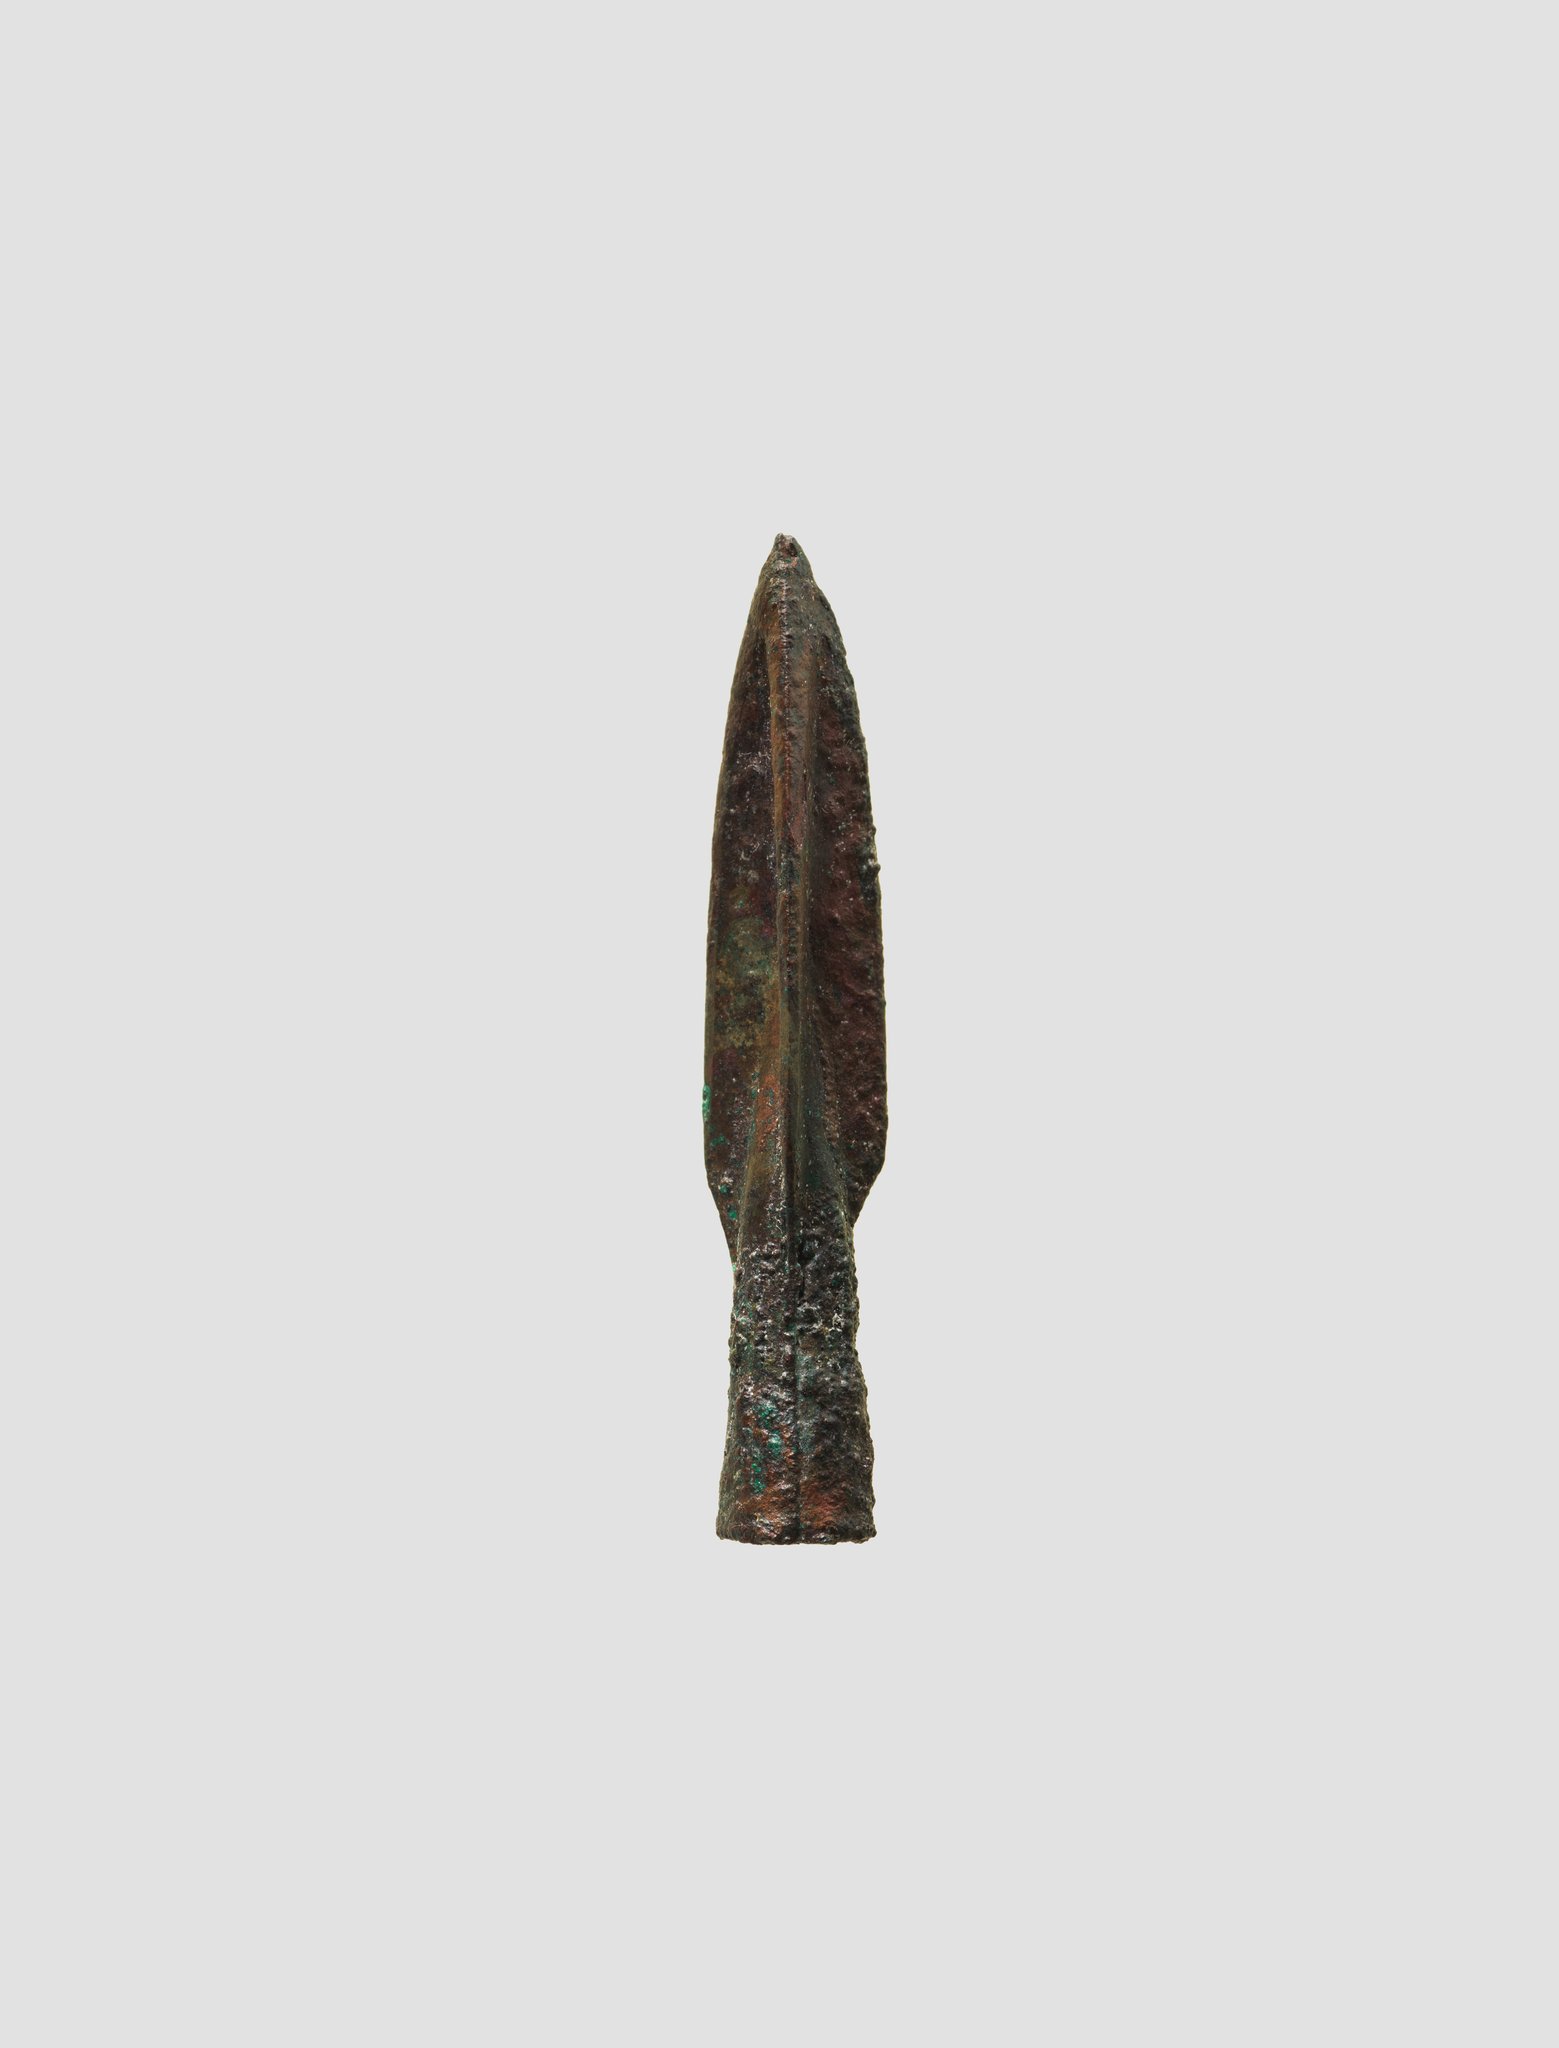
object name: arrowhead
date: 601-700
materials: bronze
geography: iran